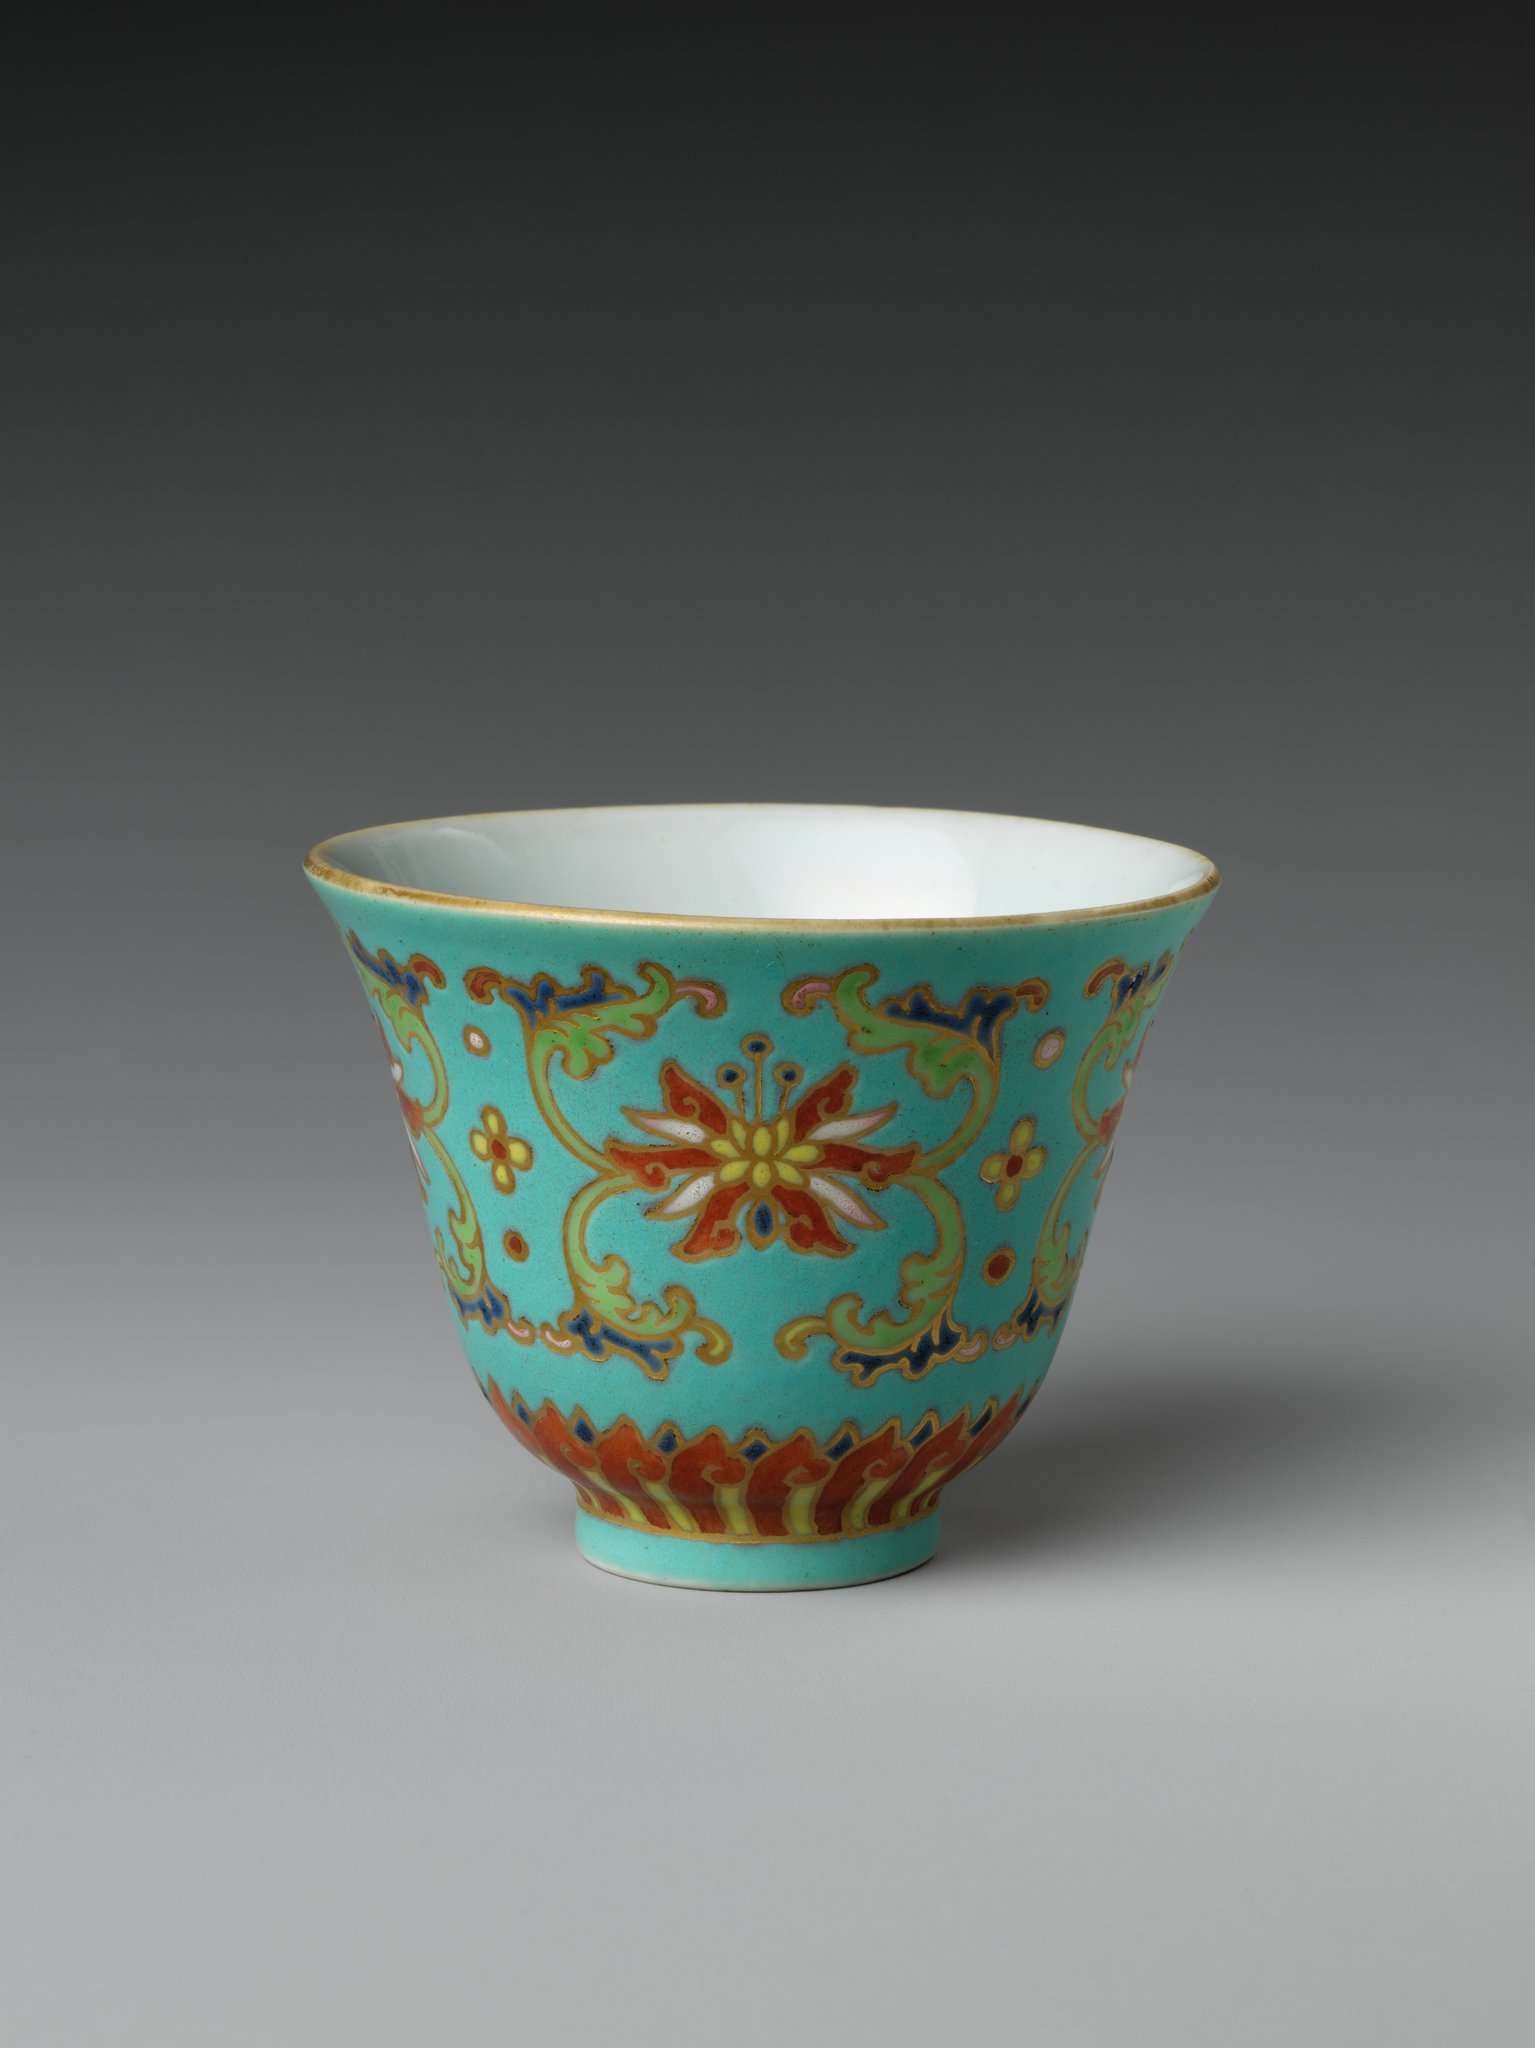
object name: cup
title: Cup with floral scrolls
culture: chinese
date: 1734-1766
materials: enamel, gold, porcelain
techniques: overglaze, painting, polychrome